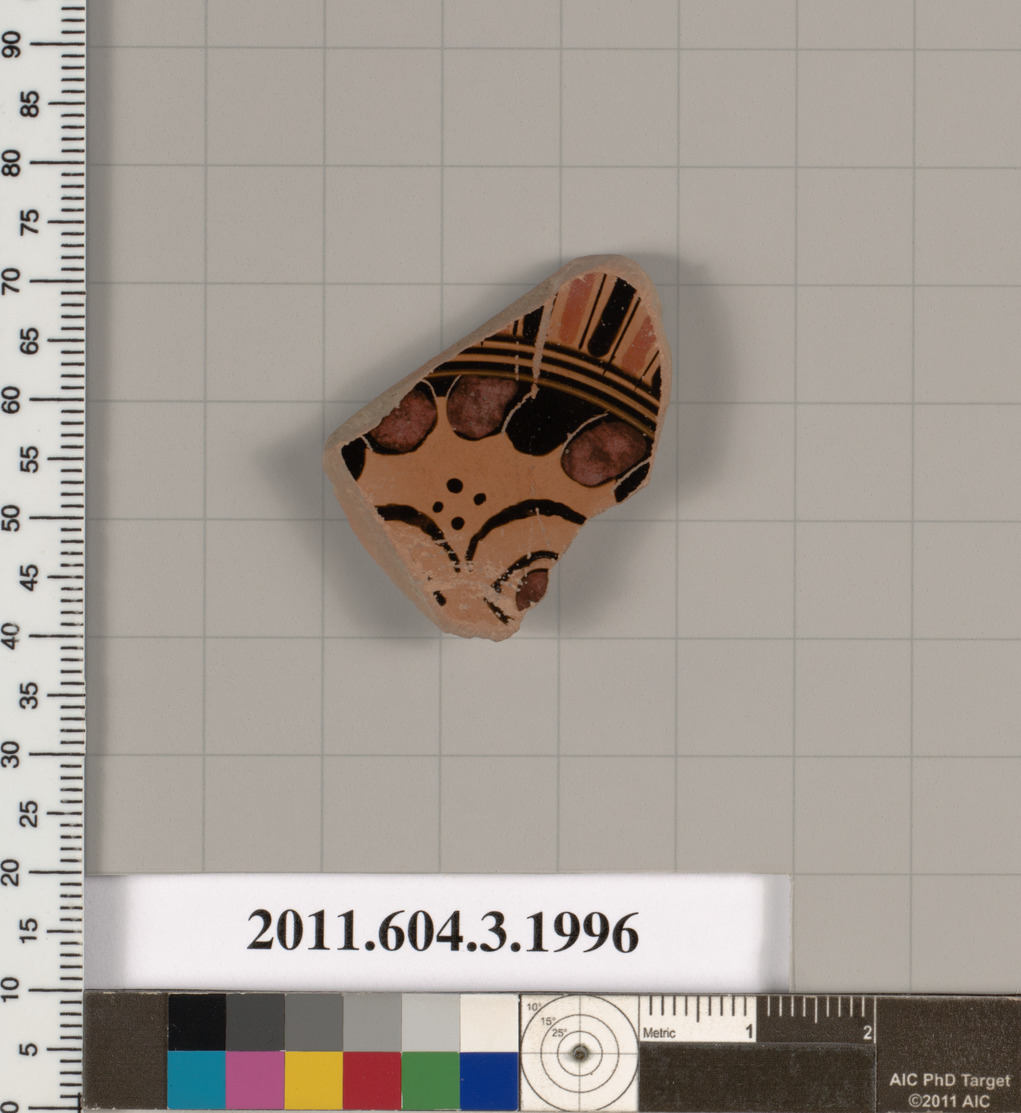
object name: kylix fragment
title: Terracotta fragment of a kylix (drinking cup)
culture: greek, attic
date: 540-530 BCE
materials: terracotta